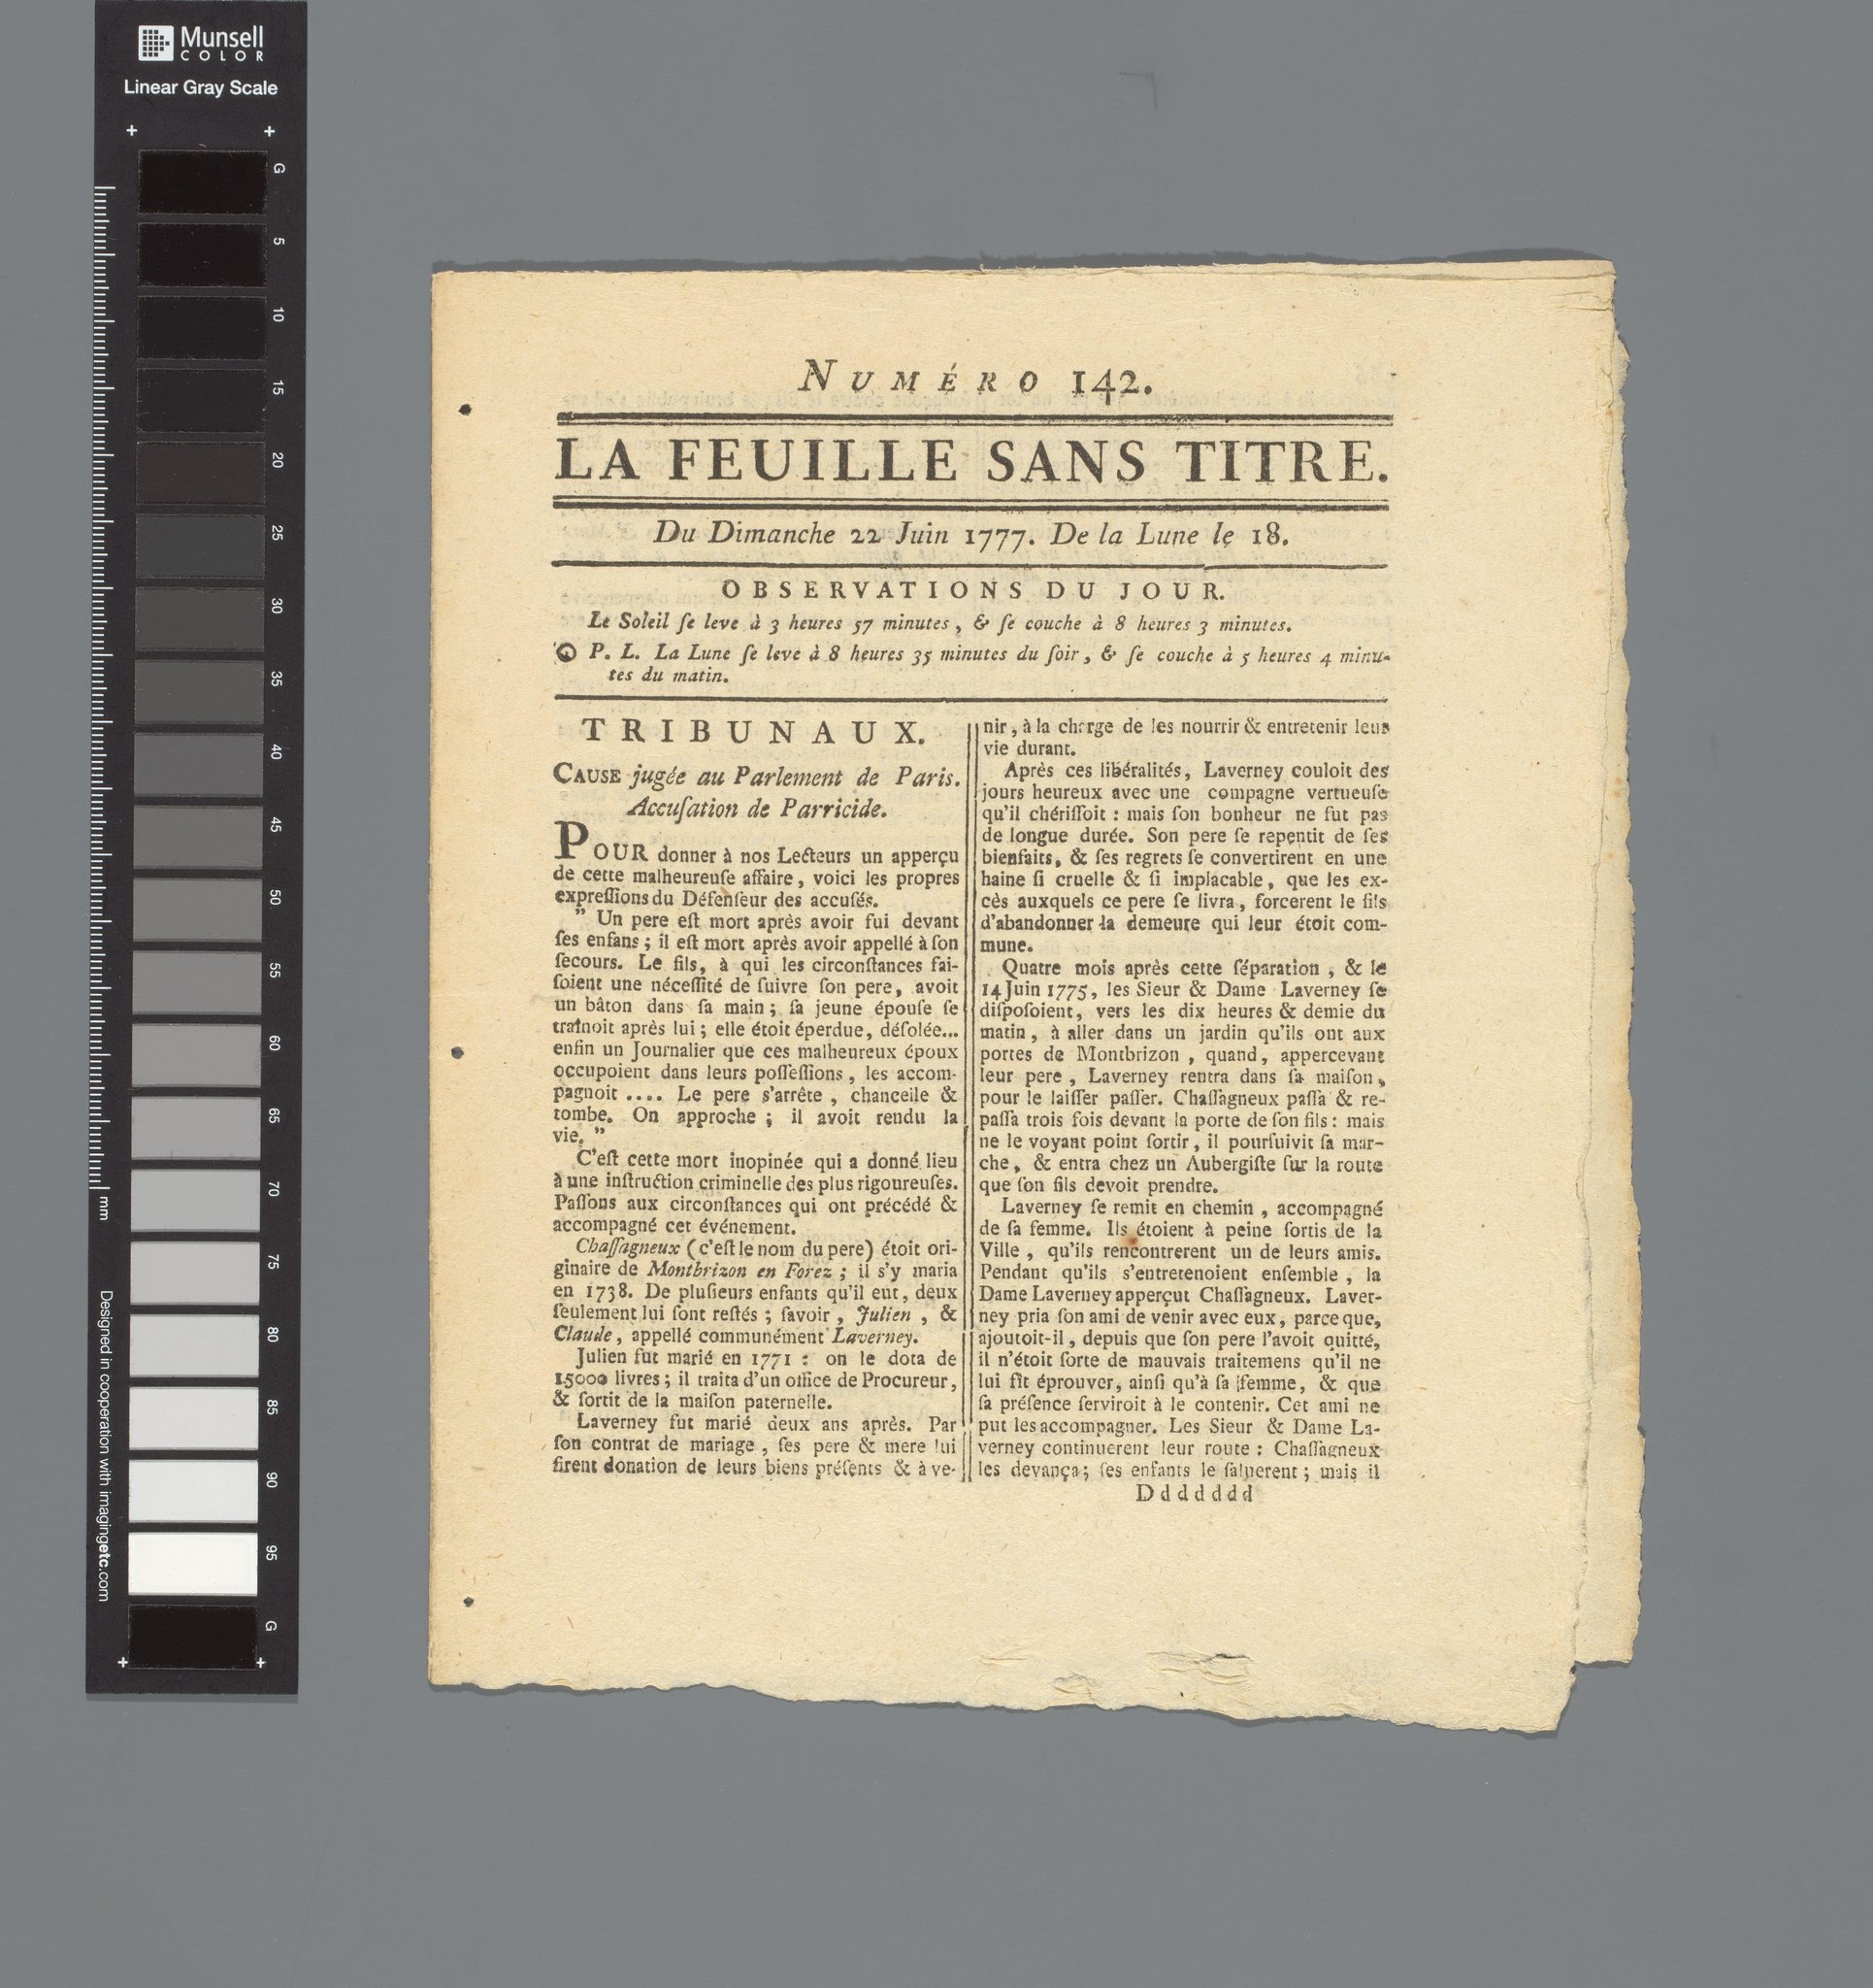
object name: fashion print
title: La Feuille sans Titre , no. 142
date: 1777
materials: ink, paper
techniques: etching, letterpress printing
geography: amsterdam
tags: fashion plates, hairdress - aa - ~ women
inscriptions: collector's mark: Lugt 2228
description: Tijdschrift van 22 juni 1777 bestaande uit vier bladzijden tekst met halve kolom over mode met in de tekst een illustratie van een haardracht met het onderschrift 'à L'aigrette Parasol. f. XI.'